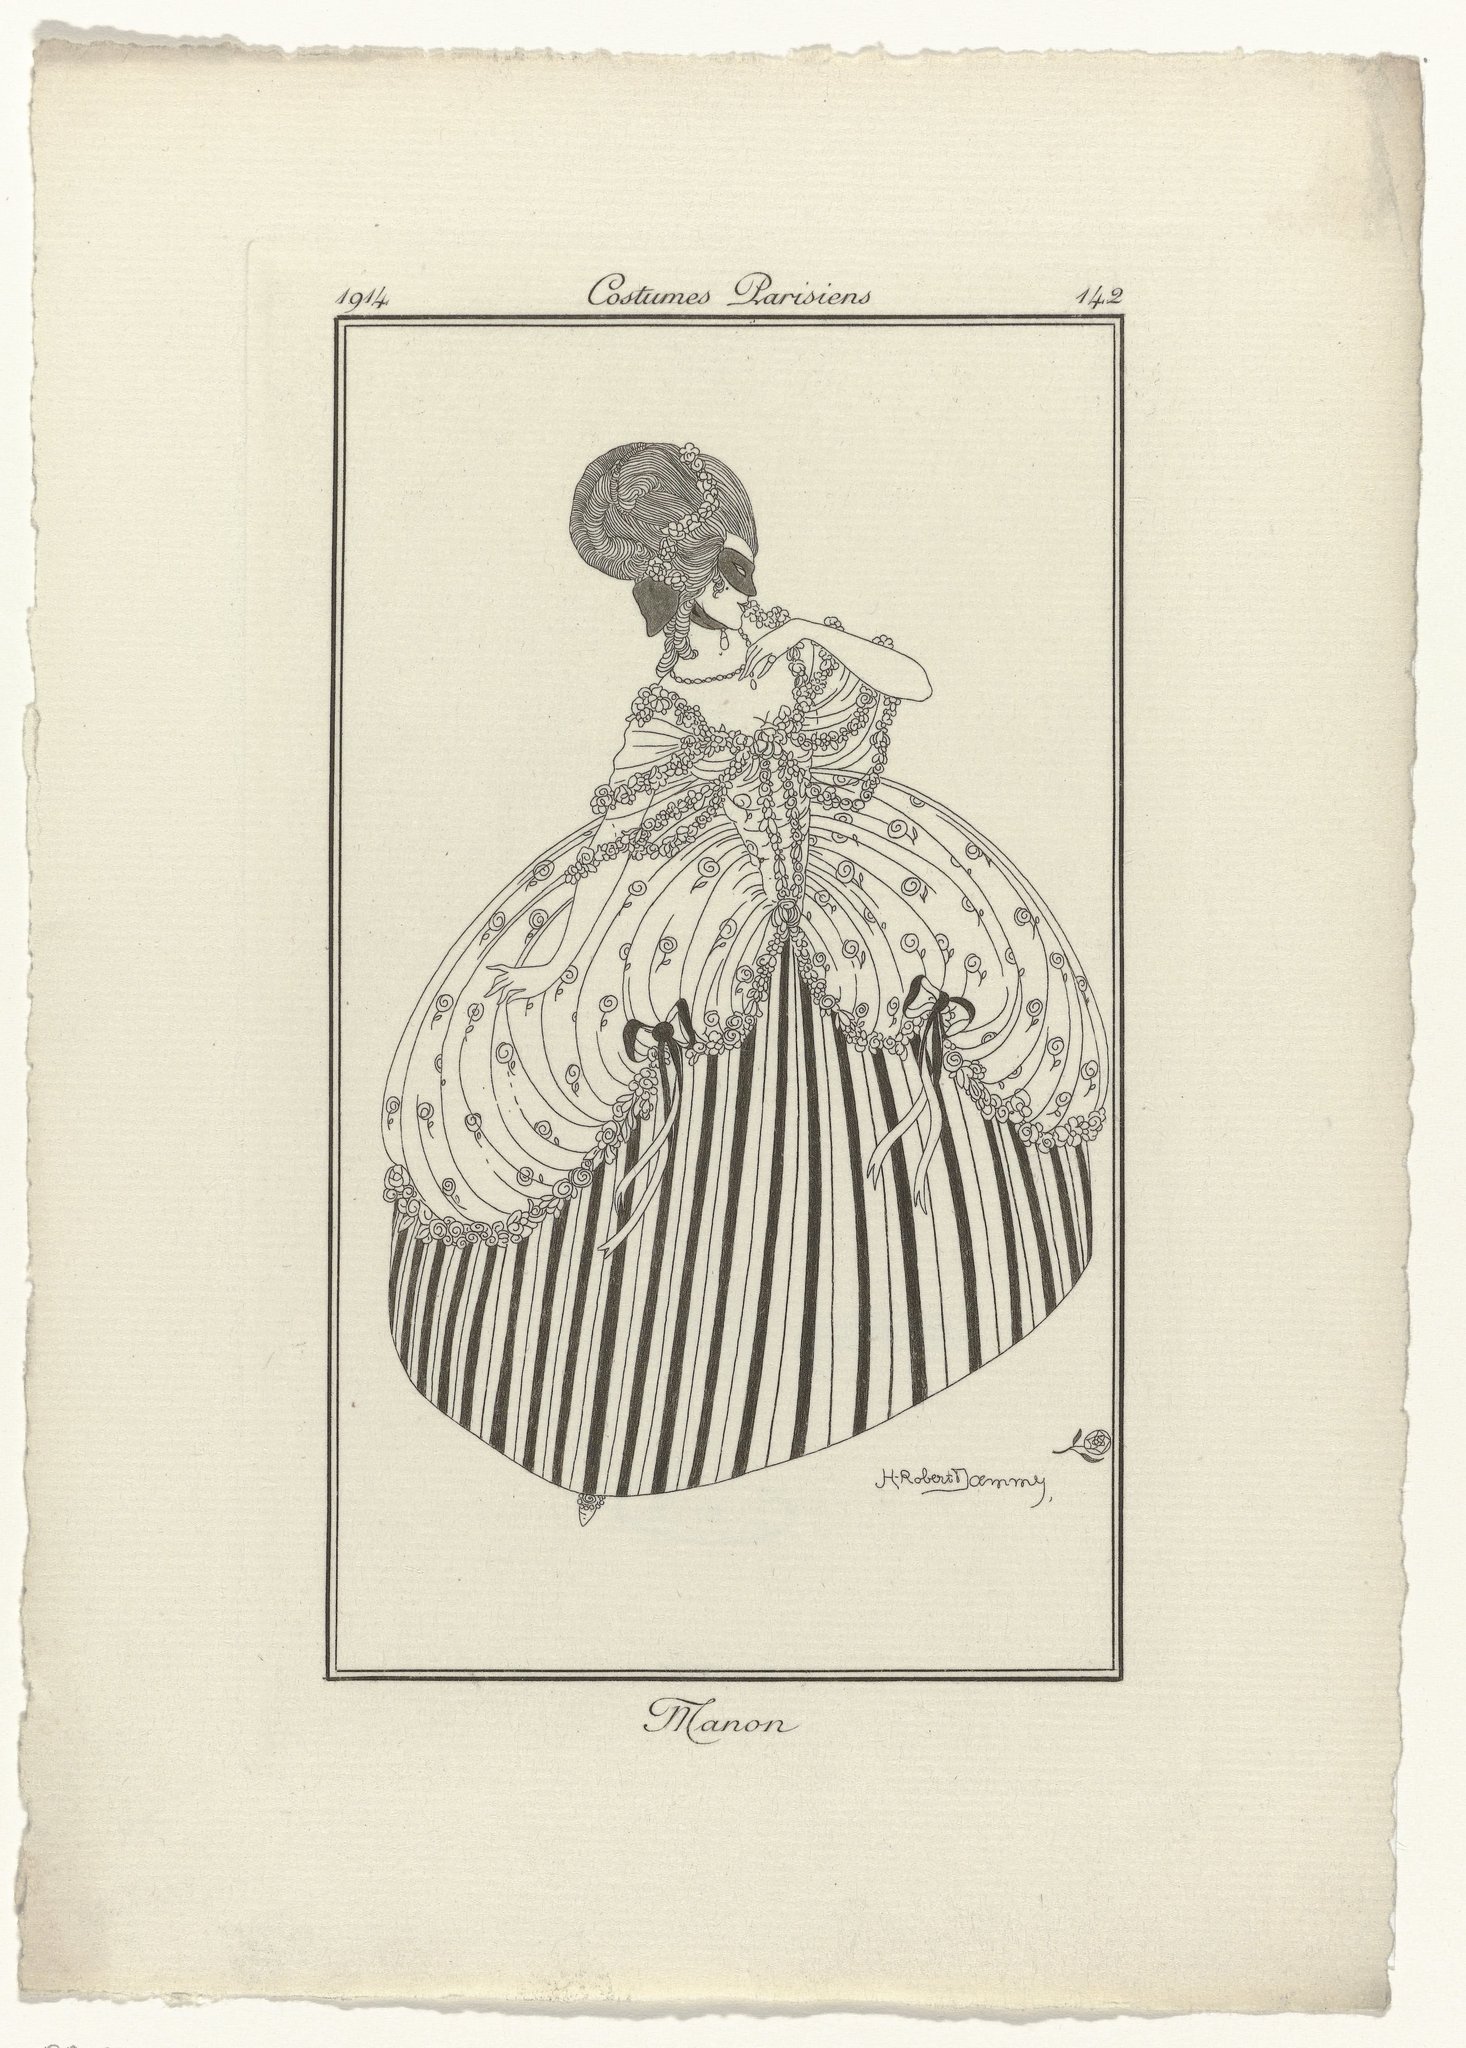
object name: fashion print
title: Journal des Dames et des Modes, Costumes Parisiens, 1914, No. 142 : Manon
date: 1914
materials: paper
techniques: engraving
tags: bow (ornamental part of clothing) (+ women's clothes), black velvet or satin mask, 'loup', 'cachenez' (+ women's clothes), historical costume (+ women's clothes), styles of hairdress - aa - ~ women, fashion plates, skirt (+ women's clothes), dress, gown (+ women's clothes), necklace (+ women's clothes)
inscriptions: title: ‘Costumes Parisiens’, caption: ‘Manon’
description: Gemaskerde vrouw gekleed in een kostuum gebaseerd op de achttiende-eeuwse opera 'Manon'. Zij draagt een japon met bloempatroon, versierd met guirlandes en strikken, op een gestreepte onderrok. Proefdruk van een prent uit het modetijdschrift Journal des Dames et des Modes (1912-1914).